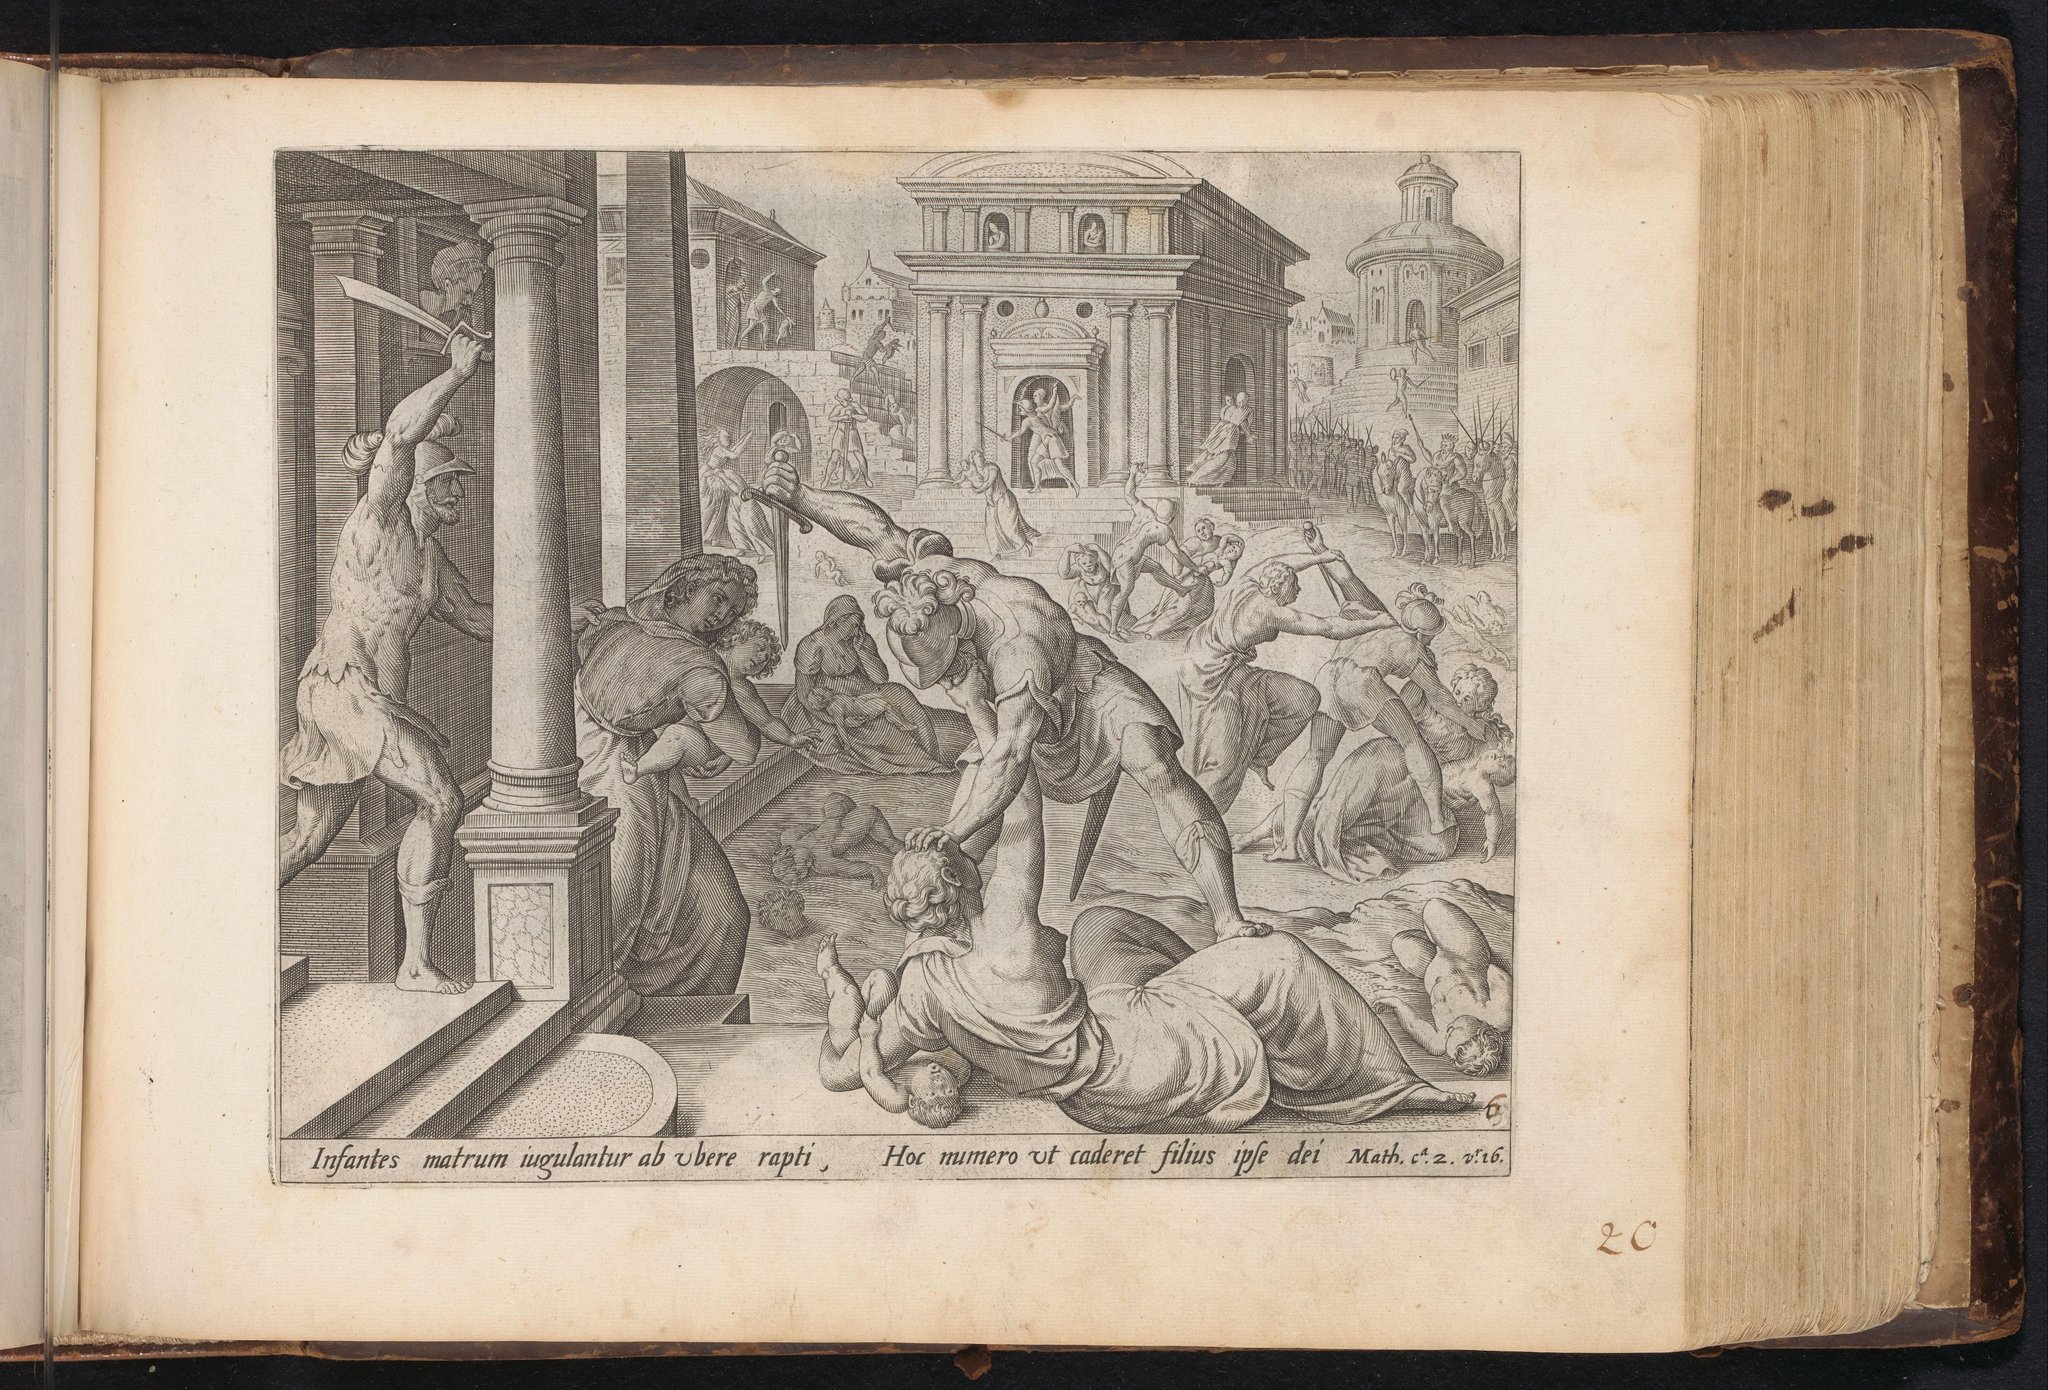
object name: album leaf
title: Kindermoord te Betlehem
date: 1572-1576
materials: paper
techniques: engraving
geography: alkmaar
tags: soldiers entering bethlehem ~ massacre of the innocents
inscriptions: number: ‘20’, serial number: ‘6’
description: In de straten van Betlehem proberen moeders hun kinderen te beschermen tegen de soldaten van Herodes. Deze hebben de opdracht gekregen alle jongens van twee jaar en jonger in Betlehem te vermoorden. Onder de voorstelling een verwijzing in het Latijn naar de Bijbeltekst in Mat. 2:16. Deze prent maakt deel uit van een album.